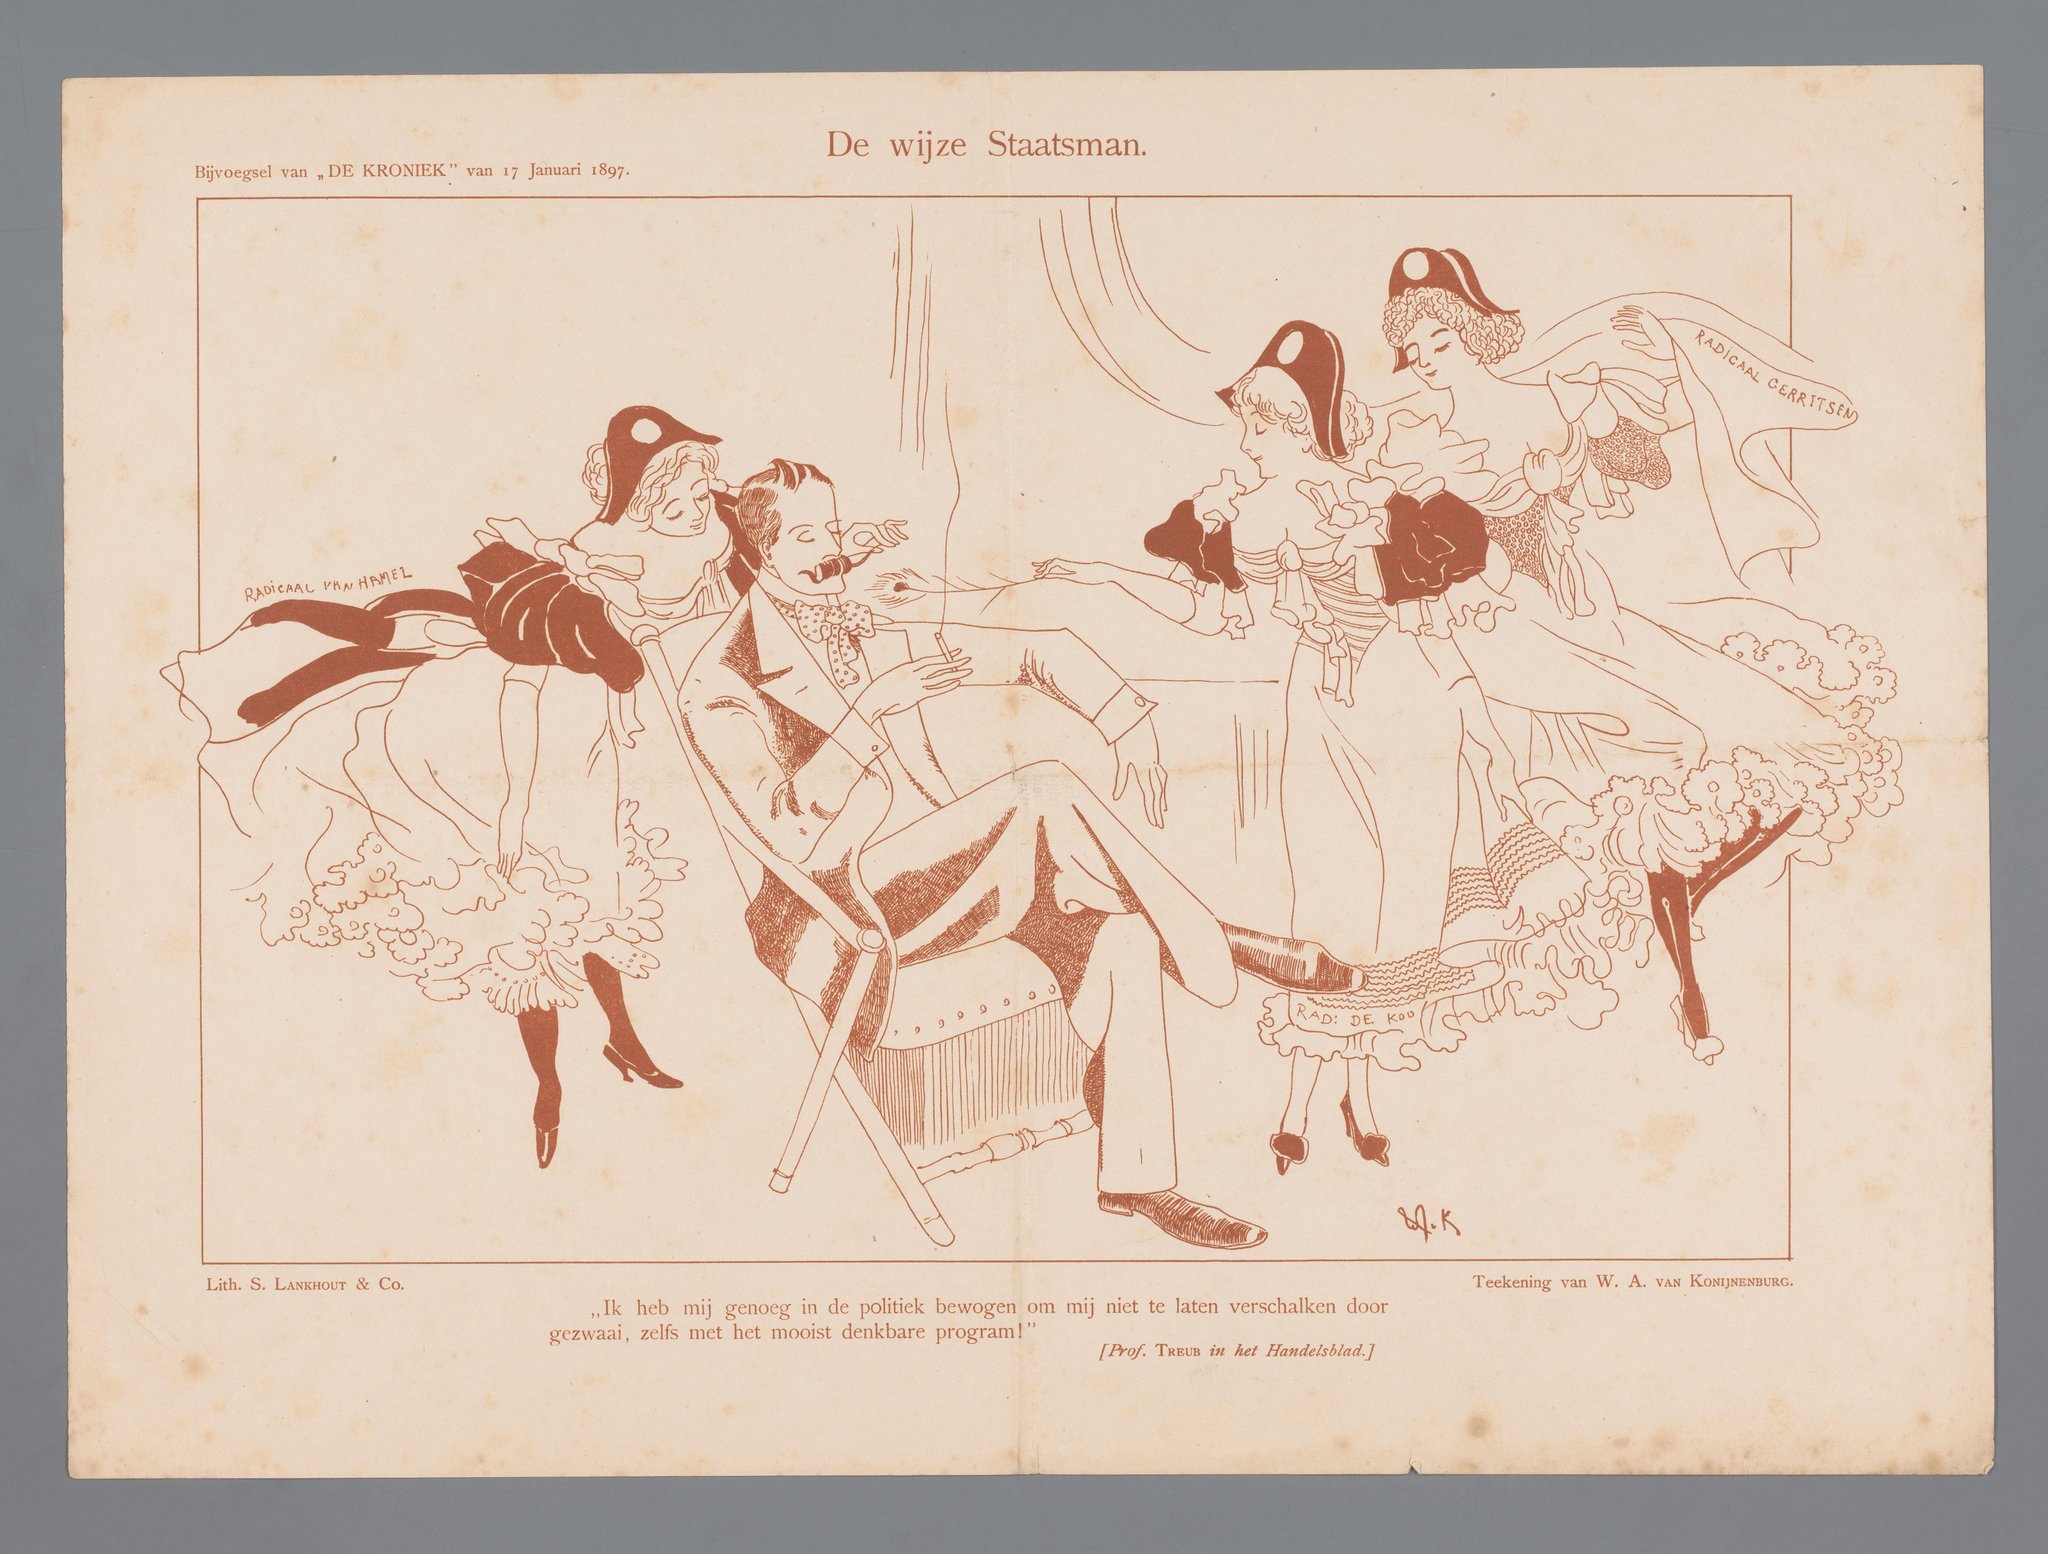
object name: cartoon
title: De wijze Staatsman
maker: willem van konijnenburg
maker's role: draughtsman, painter, print maker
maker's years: 1868-1943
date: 1897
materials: paper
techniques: lithograph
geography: the hague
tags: voorschoten, the hague, politician, political caricatures and satires, netherlands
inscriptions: date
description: Een potloodschets voor deze litho bevindt zich in de collectie van het Drents Museum in Assen.